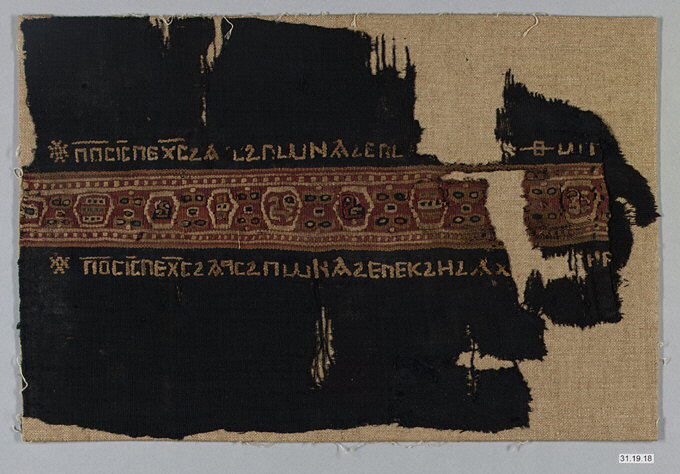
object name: textile fragment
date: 701-900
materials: linen, wool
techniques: weave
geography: egypt